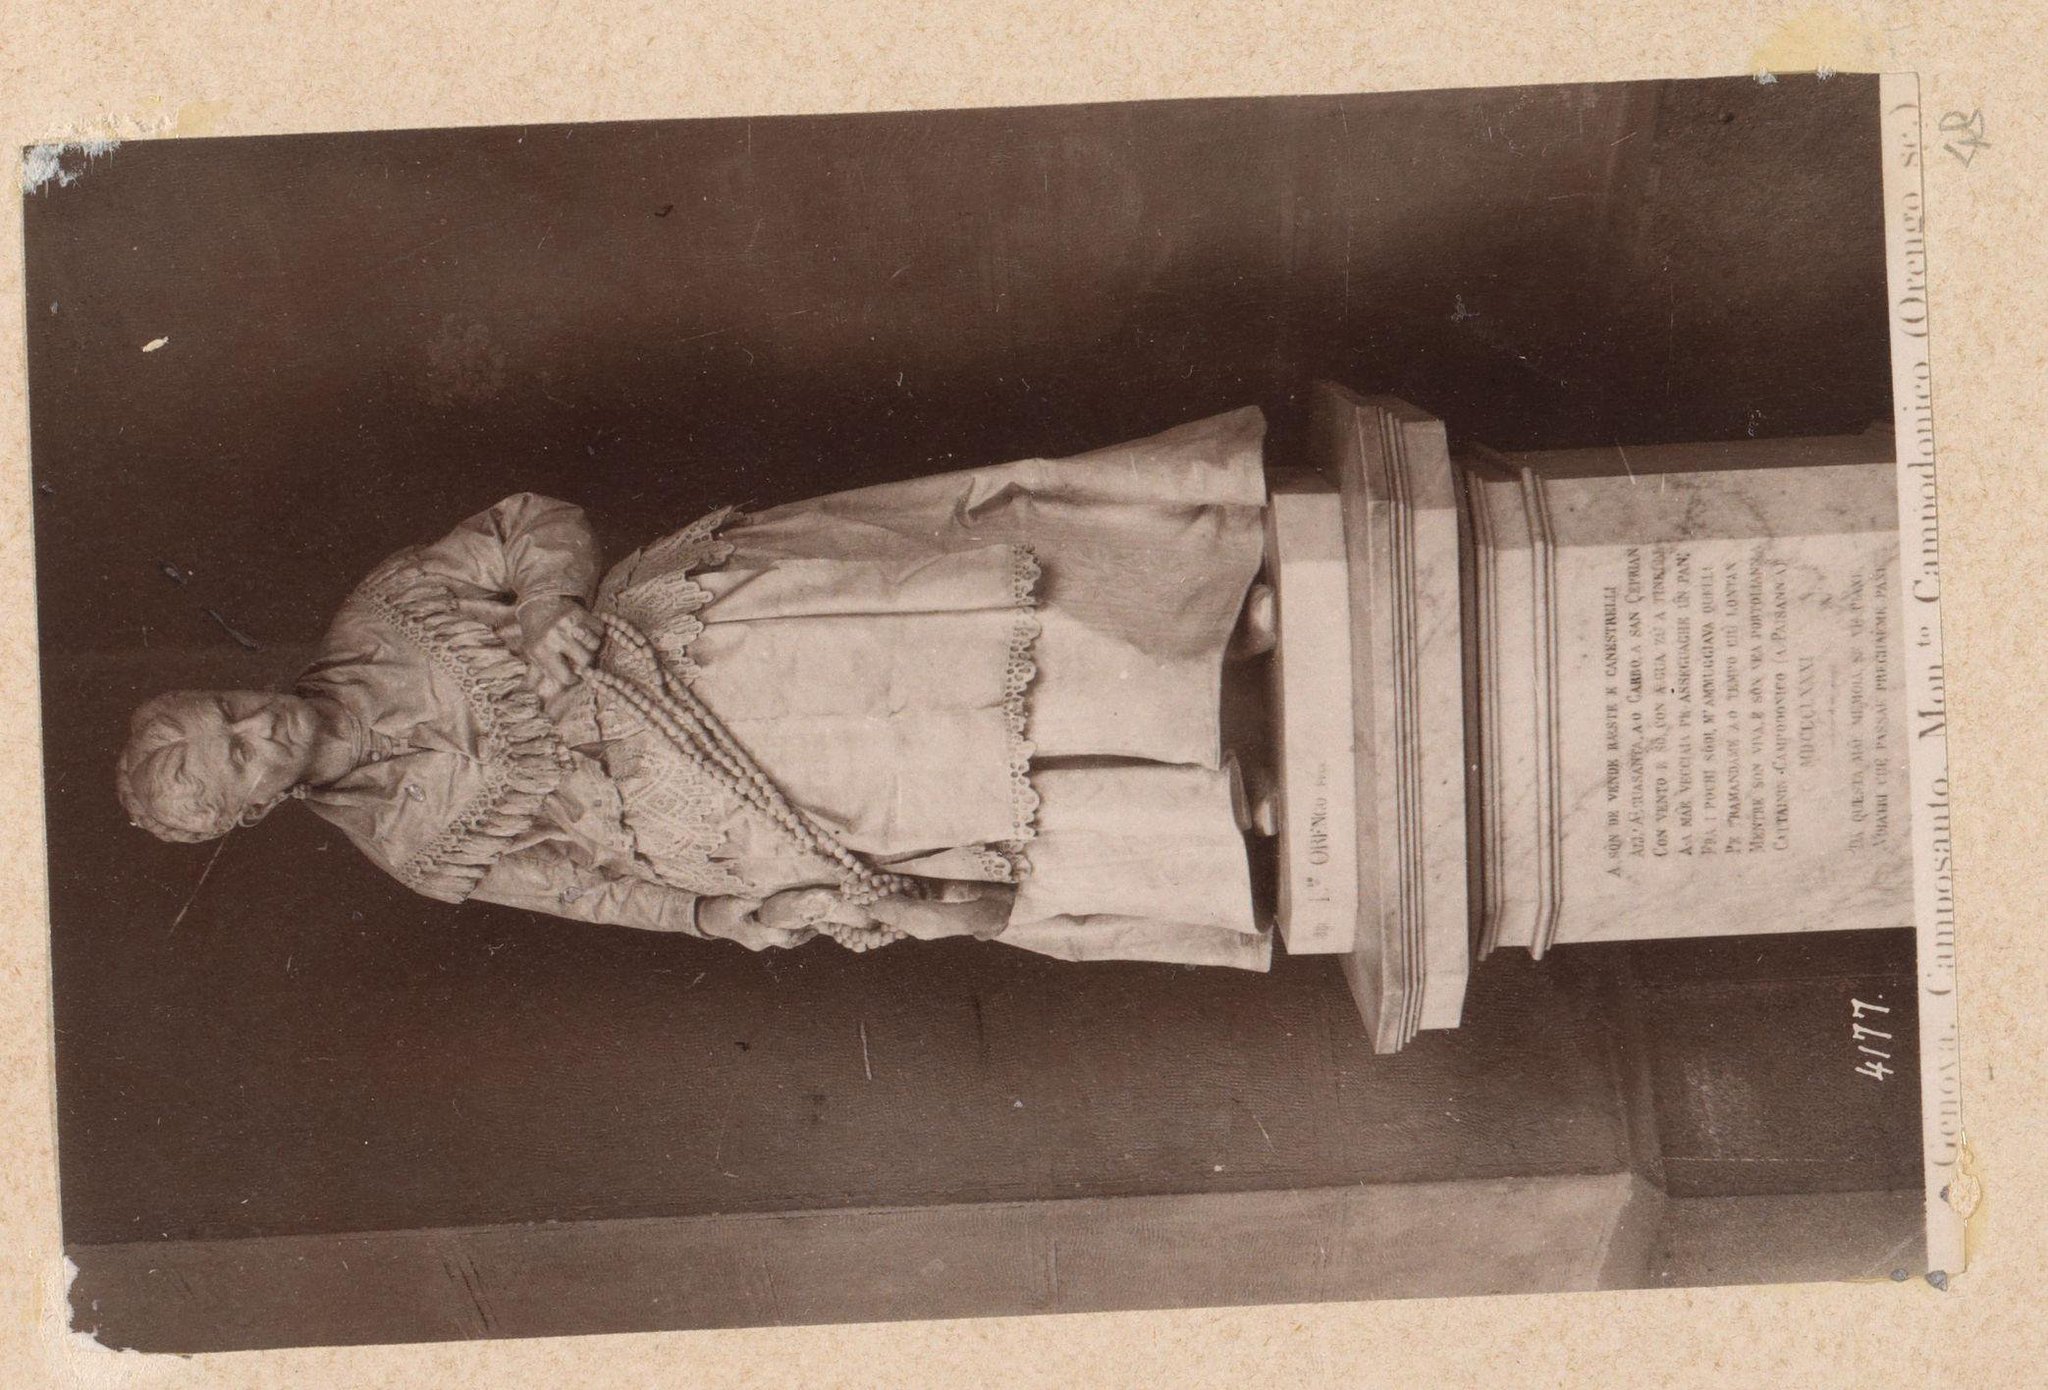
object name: photograph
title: Genova. Camposanto. Mon. Da Costa. S[(...)]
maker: Anonymous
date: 1870-1900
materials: paper, photographic support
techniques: albumen print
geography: genoa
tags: piece of sculpture, reproduction of a piece of sculpture (+ sculpture), grave-building, monumental tomb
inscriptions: negative number: ‘4155’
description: Onderdeel van Reisalbum met foto's van bezienswaardigheden in Italië en Zuid-Frankrijk.